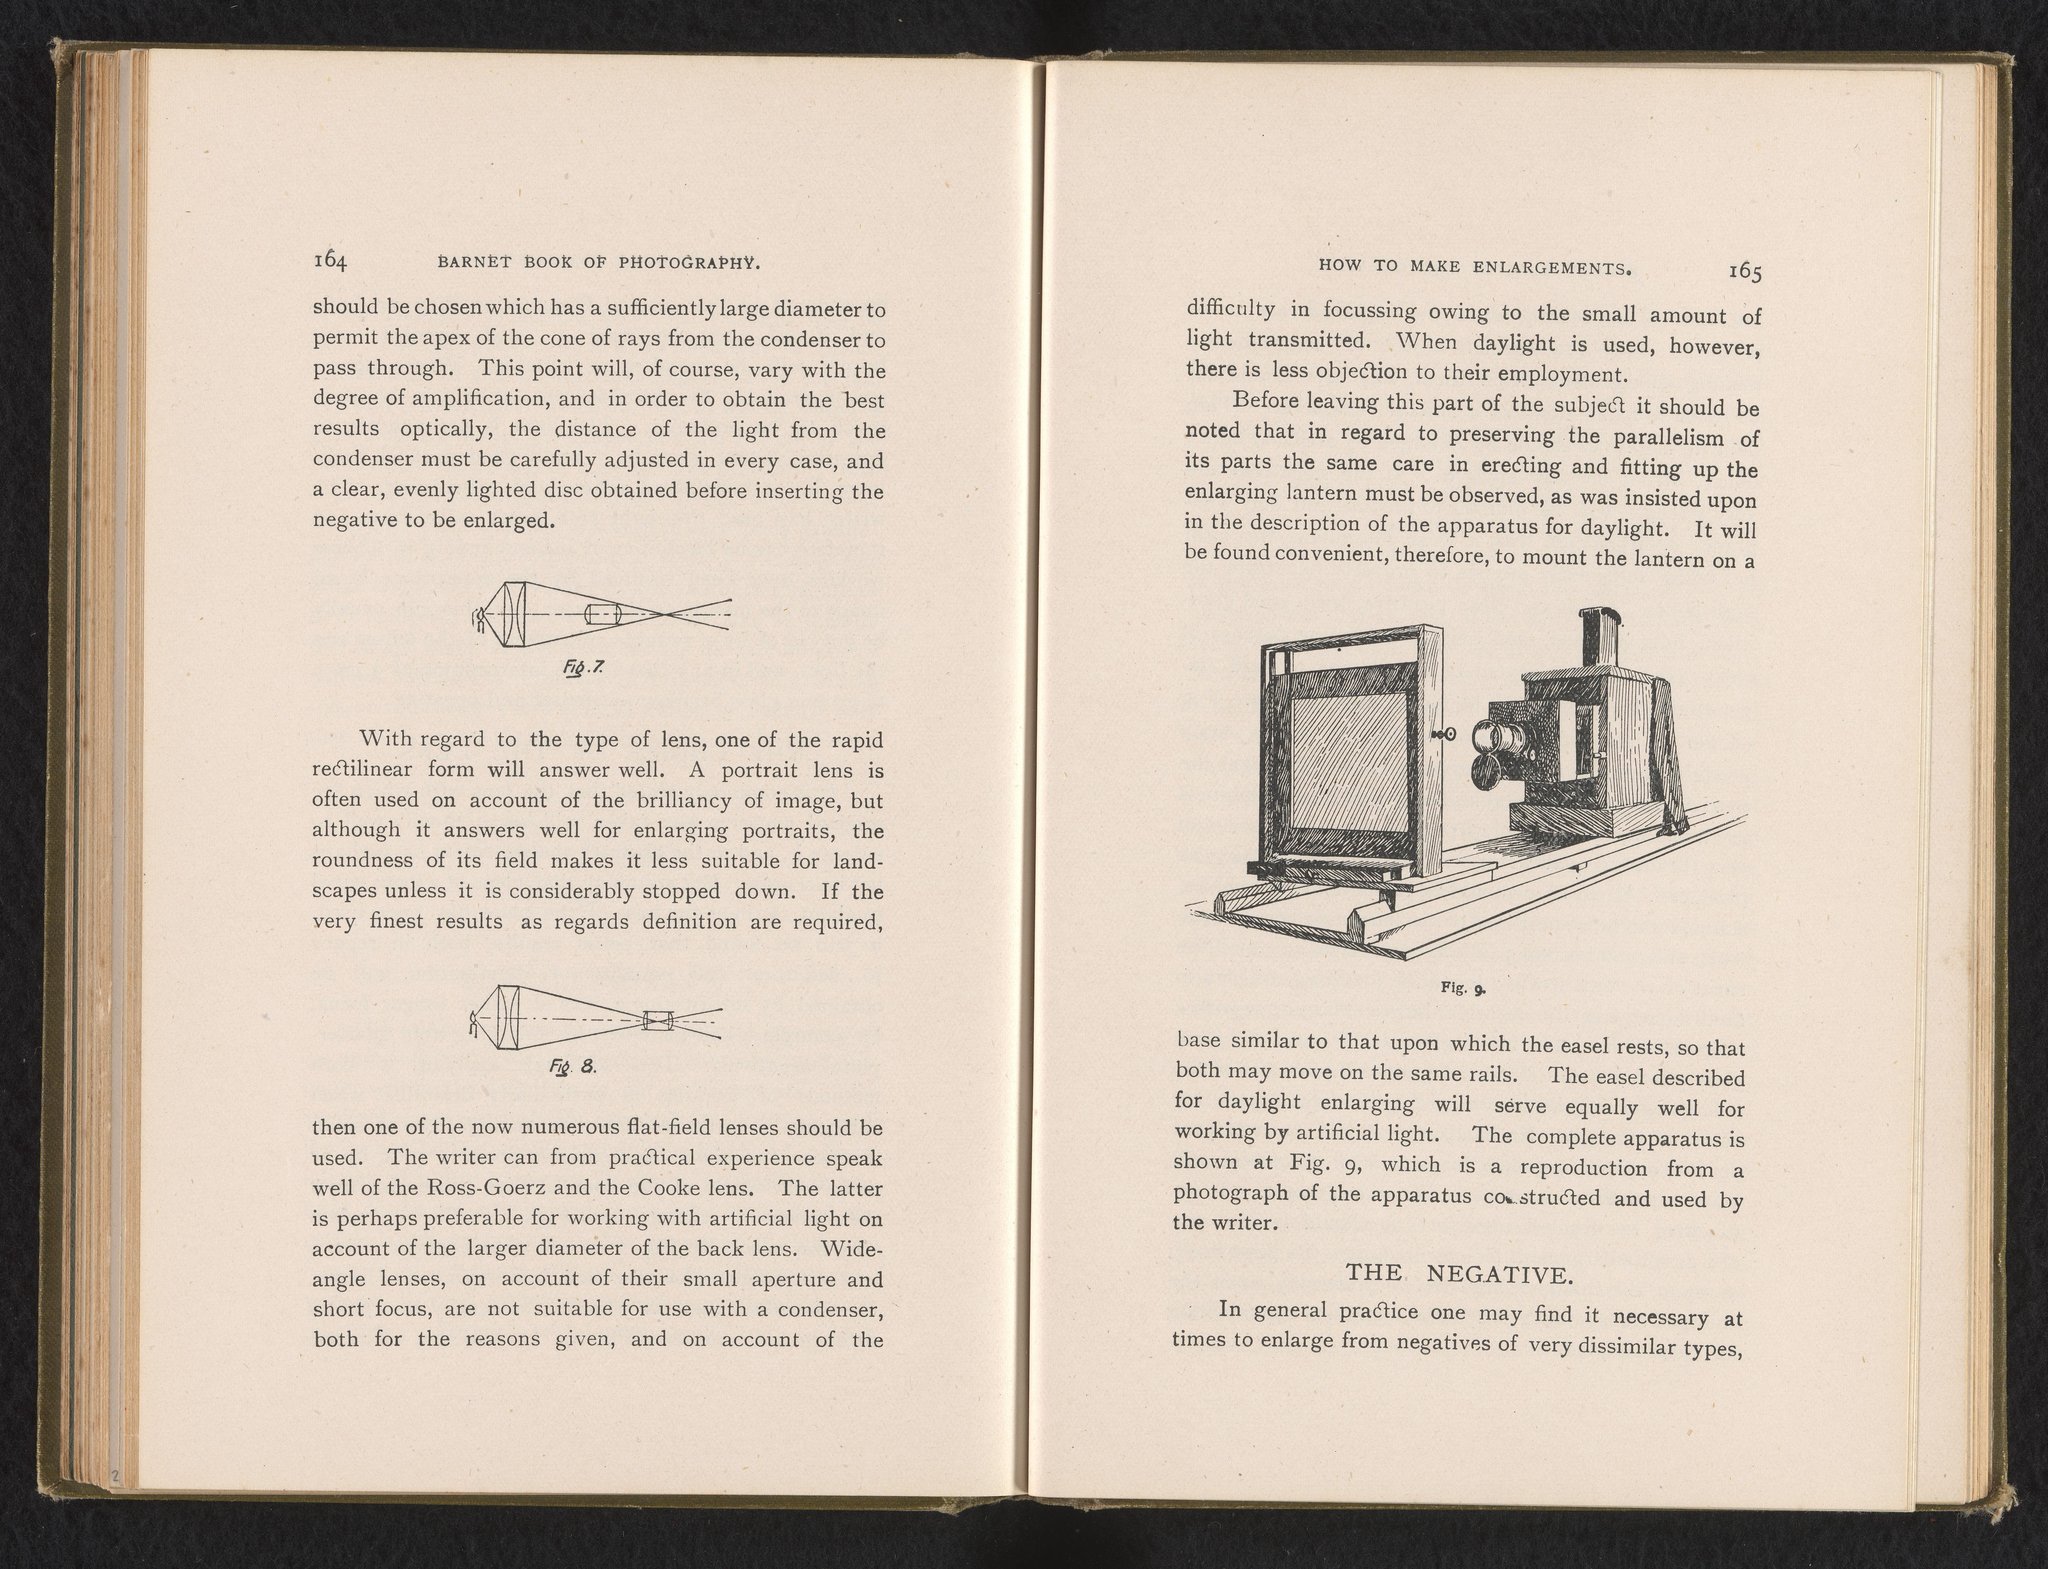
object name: page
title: Opstelling voor het maken van vergrotingen van fotonegatieven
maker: Anonymous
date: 1895-1900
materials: paper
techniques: letterpress printing, line block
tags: camera ~ photography, photographic apparatus